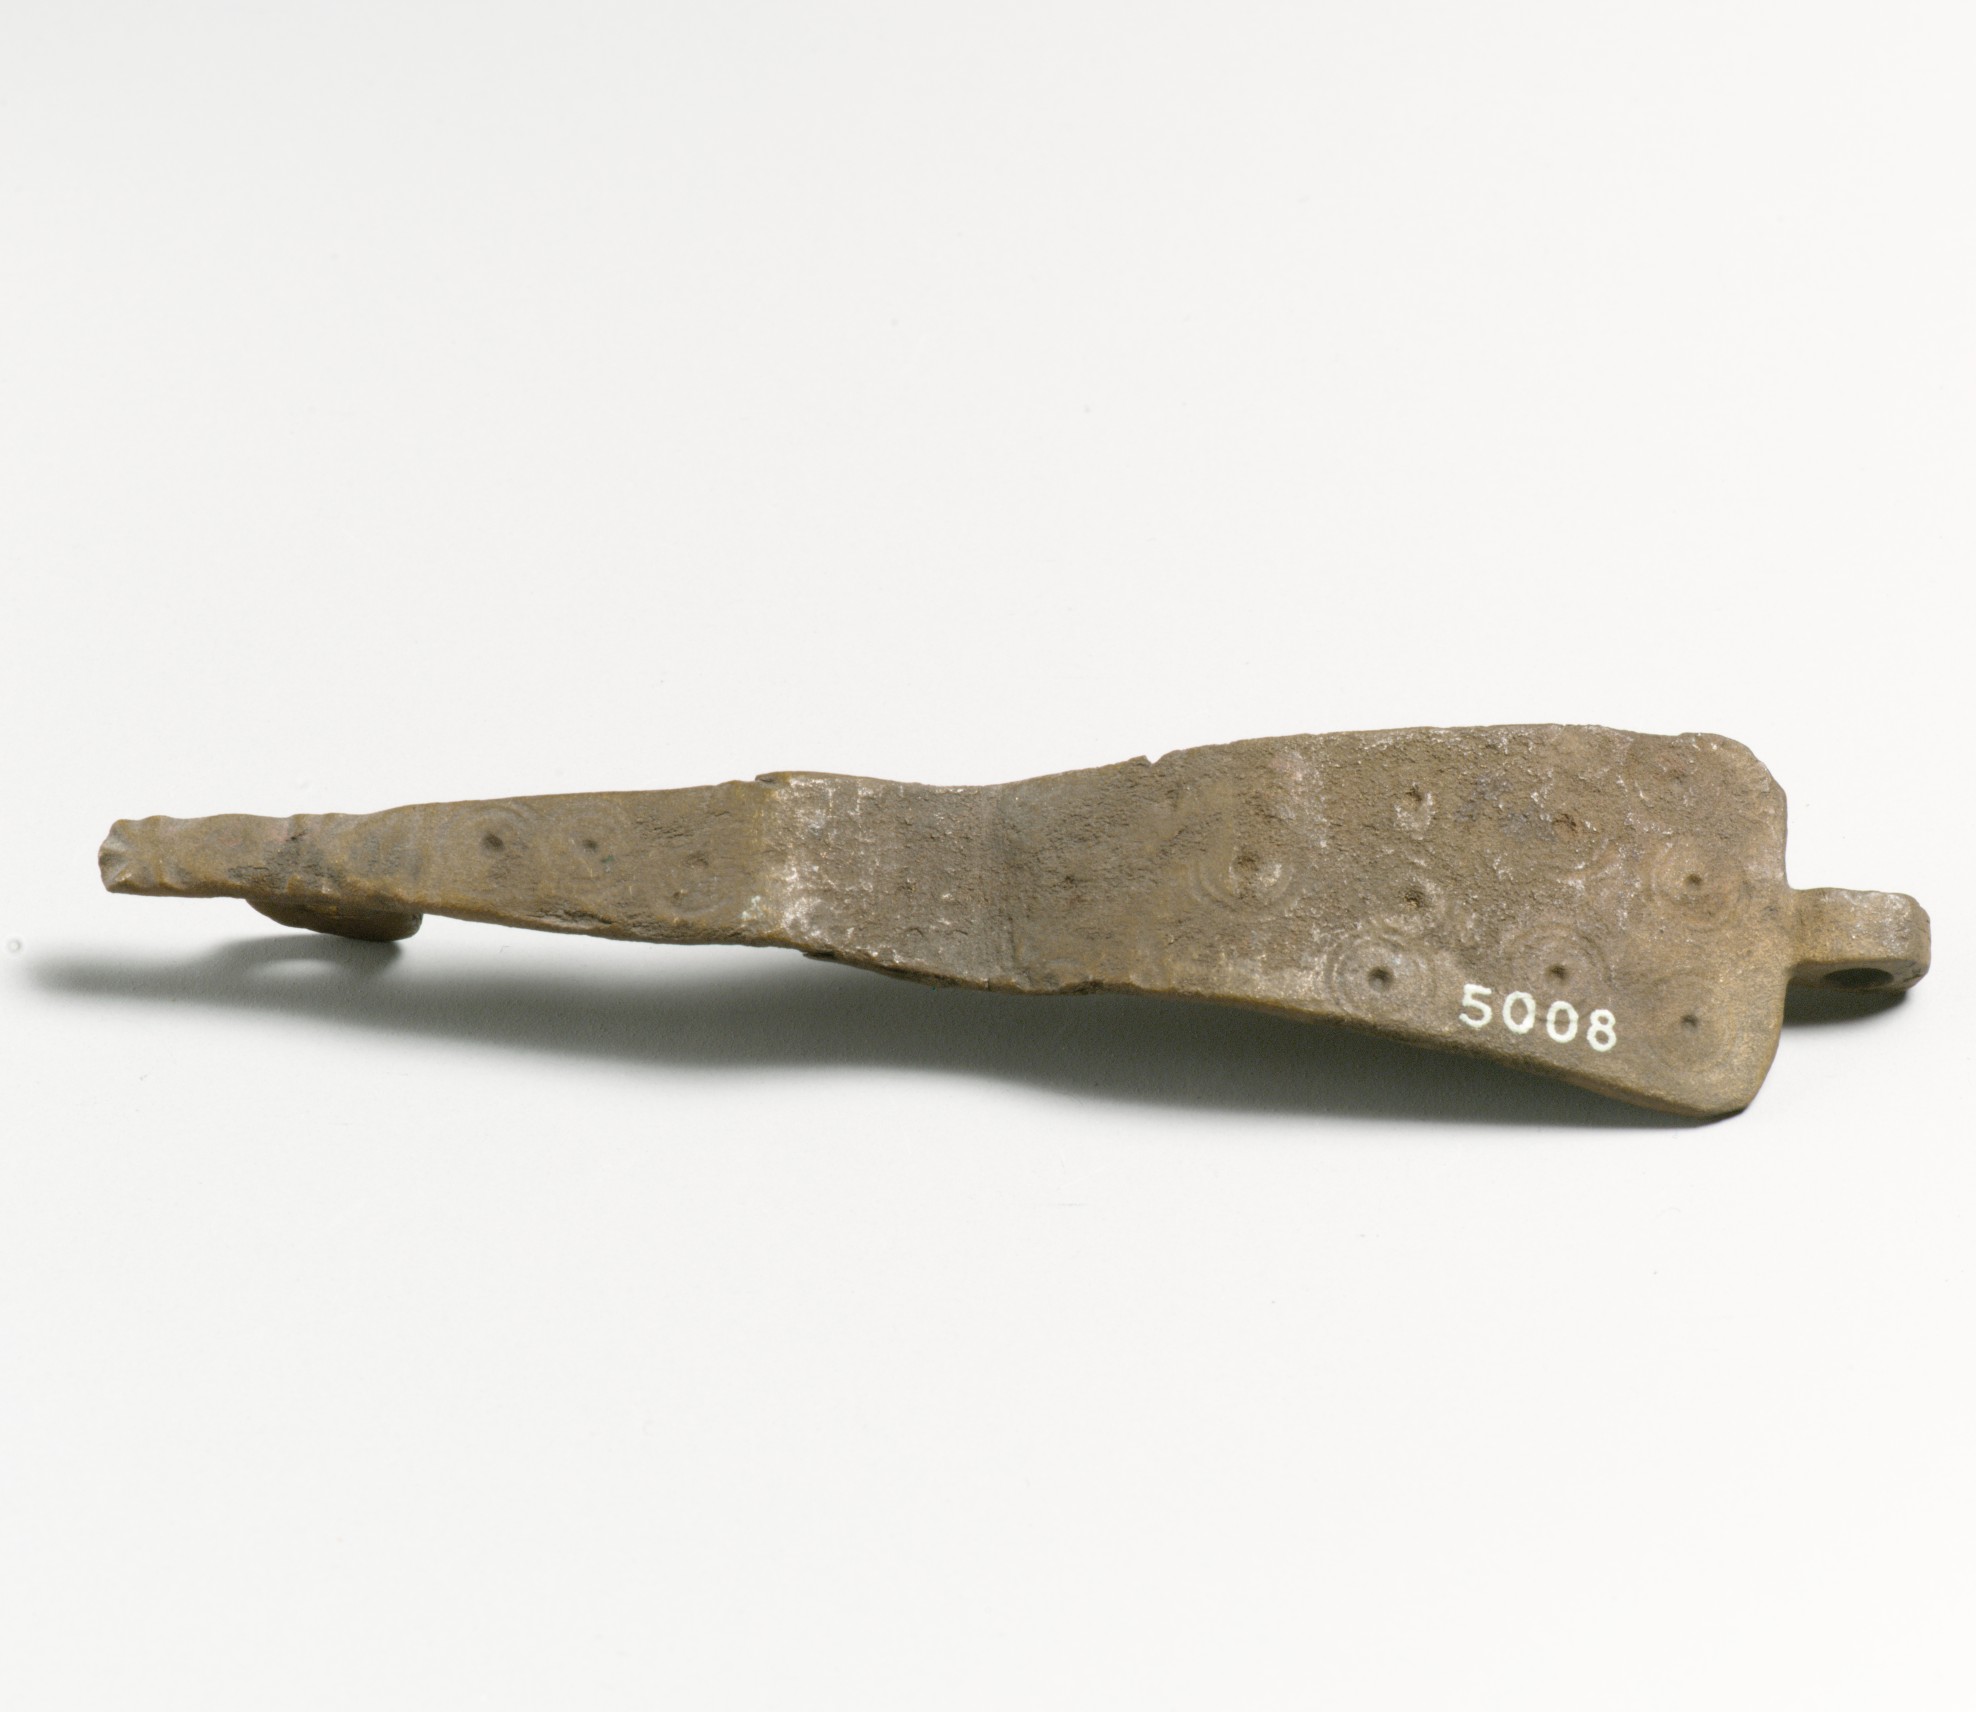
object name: hasp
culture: cypriot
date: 3900 BCE-100 CE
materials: bronze